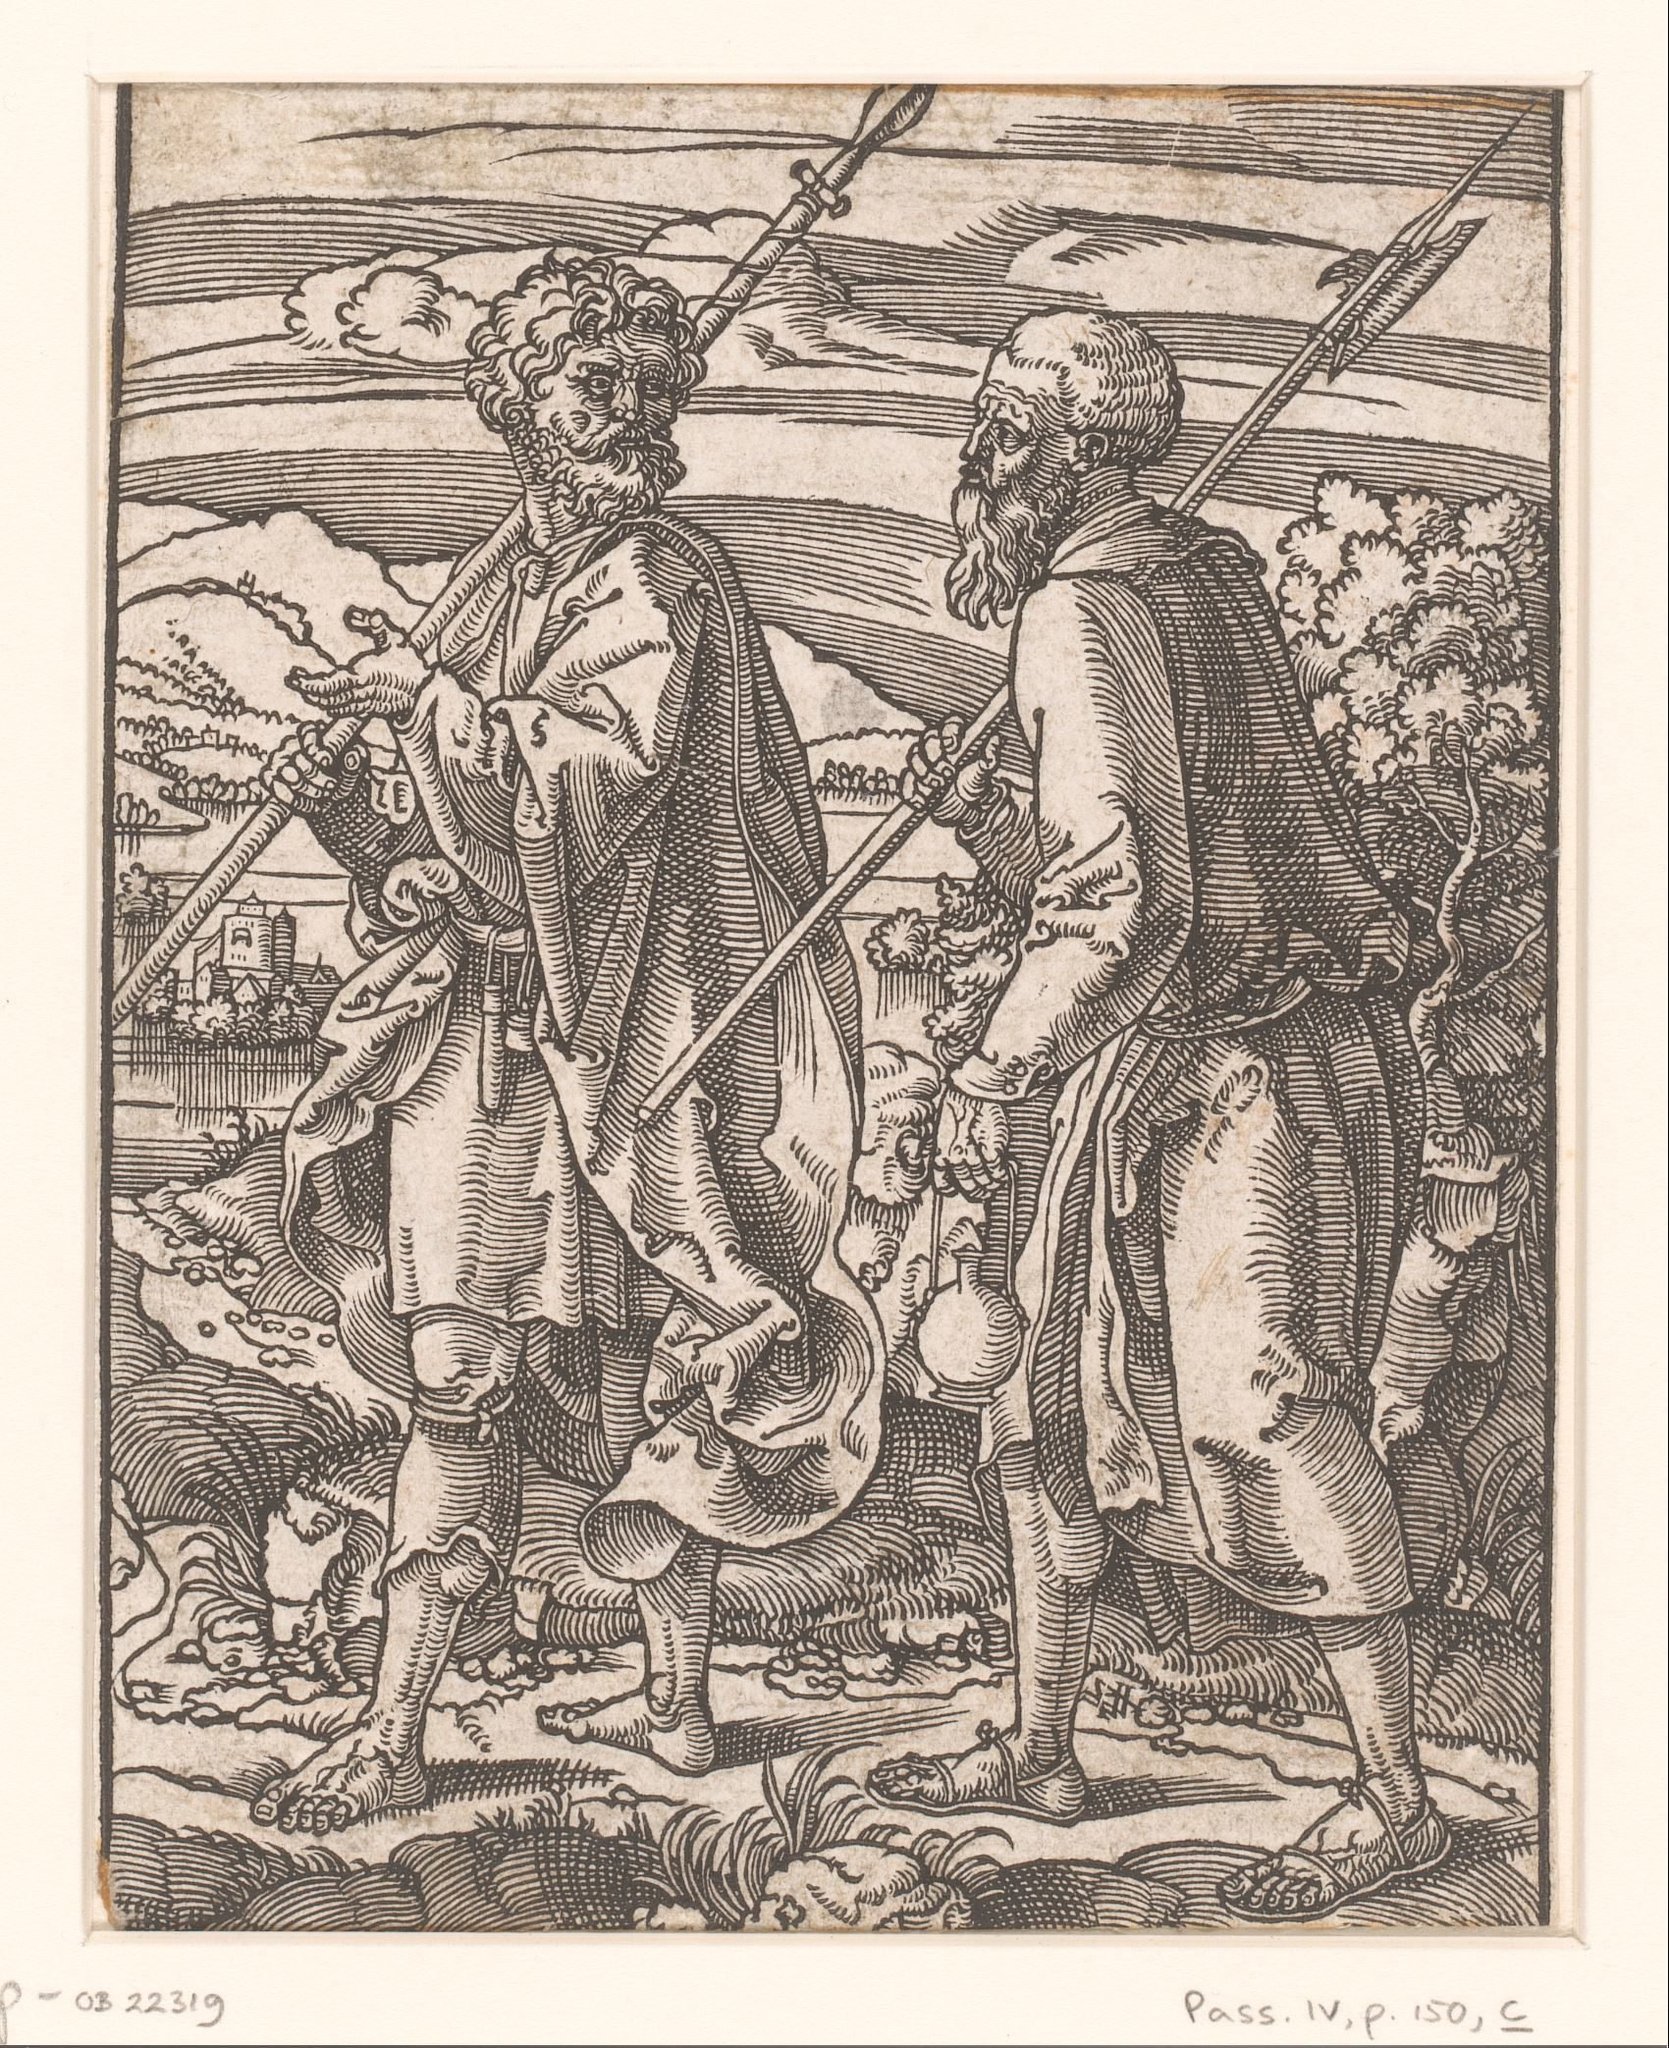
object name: print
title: Apostelen Tomas en Matthias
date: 1529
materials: paper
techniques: woodcut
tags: the apostle thomas; possible attributes: book, chalice, girdle, heart, lance or spear, scroll, square, stones, the apostle and evangelist matthew (mattheus); possible attributes: angel, axe, book, halberd, pen and inkhorn, purse, scroll, square, sword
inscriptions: collector's mark: Lugt 240